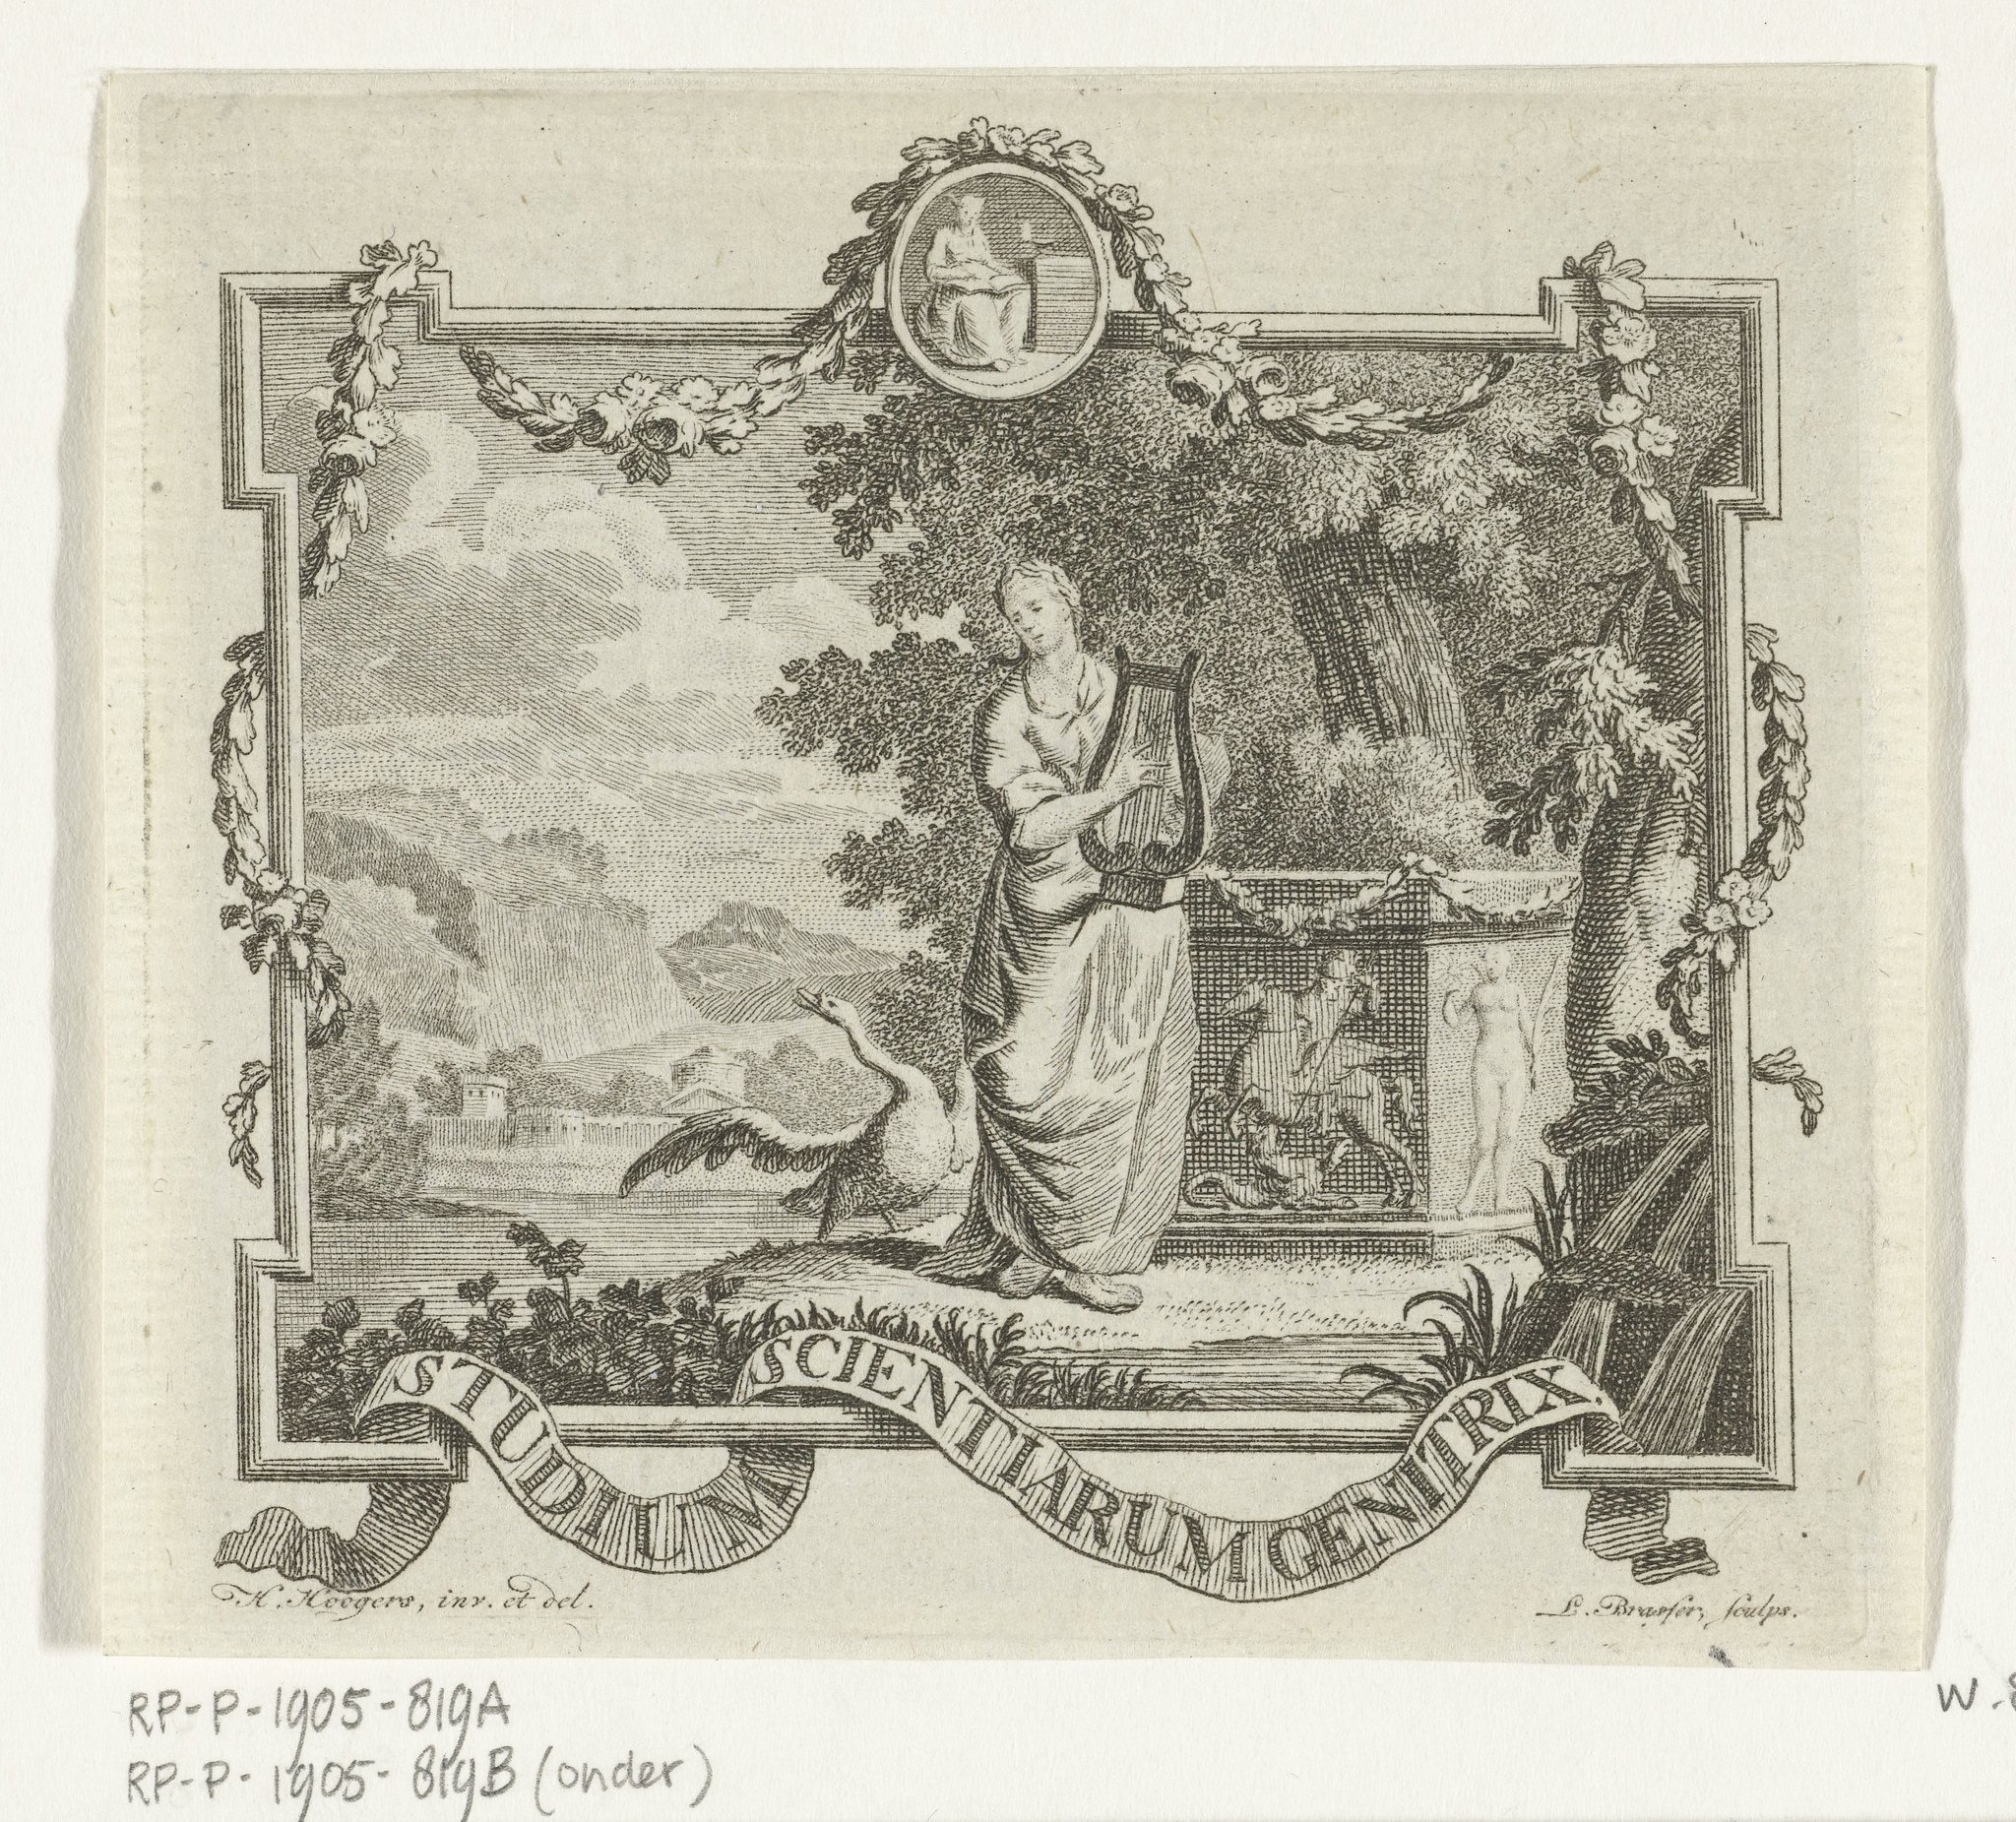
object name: print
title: Vignet met Poëzie met lier en zwaan in landschap met omlijsting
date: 1727-1793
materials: paper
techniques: etching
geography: rotterdam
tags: water-birds: swan, symbolic representations, allegories and emblems ~ poetry; 'poesia' (ripa), (story of) bellerophon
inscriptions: collector's mark: Lugt 2228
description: Vignet met vrouwelijk personificatie van de Poëzie die een lier bespeelt op de oever van een water in een zuidelijk landschap. Achter haar staat een sokkel met in reliëf Bellerophon die de Chimaera verslaat, een zwaan op de oever spreidt zijn vleugels. In een klein medaillon is de Waarheid weergegeven. Om een lijst slingeren een guirlande en een banderol met motto Studium scientiarum genitrix.